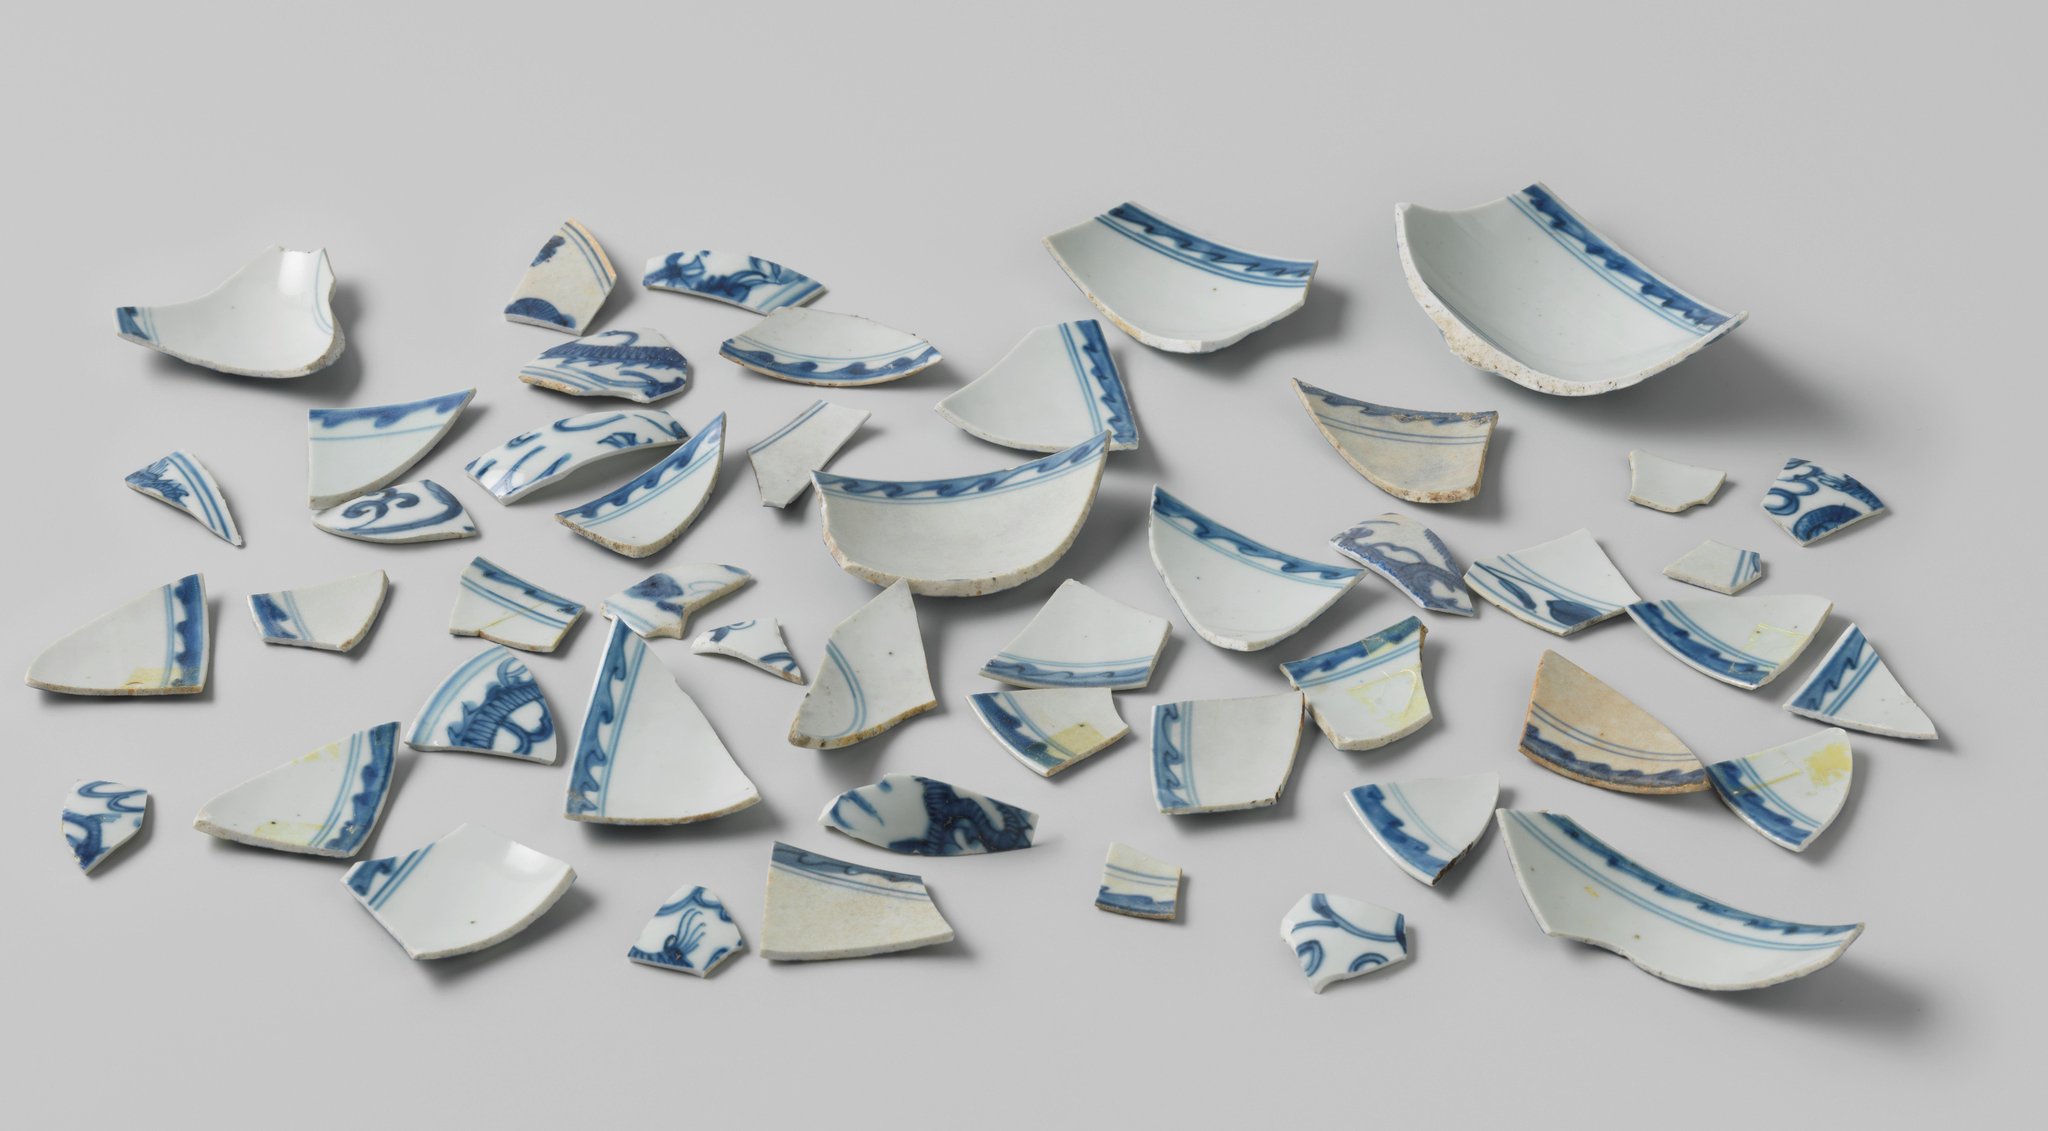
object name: bowl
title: Scherven van kommen uit V.O.C.-schip de 'Witte Leeuw'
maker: Anonymous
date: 1613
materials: porcelain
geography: jingdezhen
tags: verenigde oostindische compagnie, sint-helena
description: A bowl. The cobalt blue is of a dark purple colour. In the centre the character for a long life: shou is drawn, encircled by a double band. On the lip-rim a stylized wave band is drawn. The outside wall is decorated with two four-clawed dragons chasing a flaming pearl.